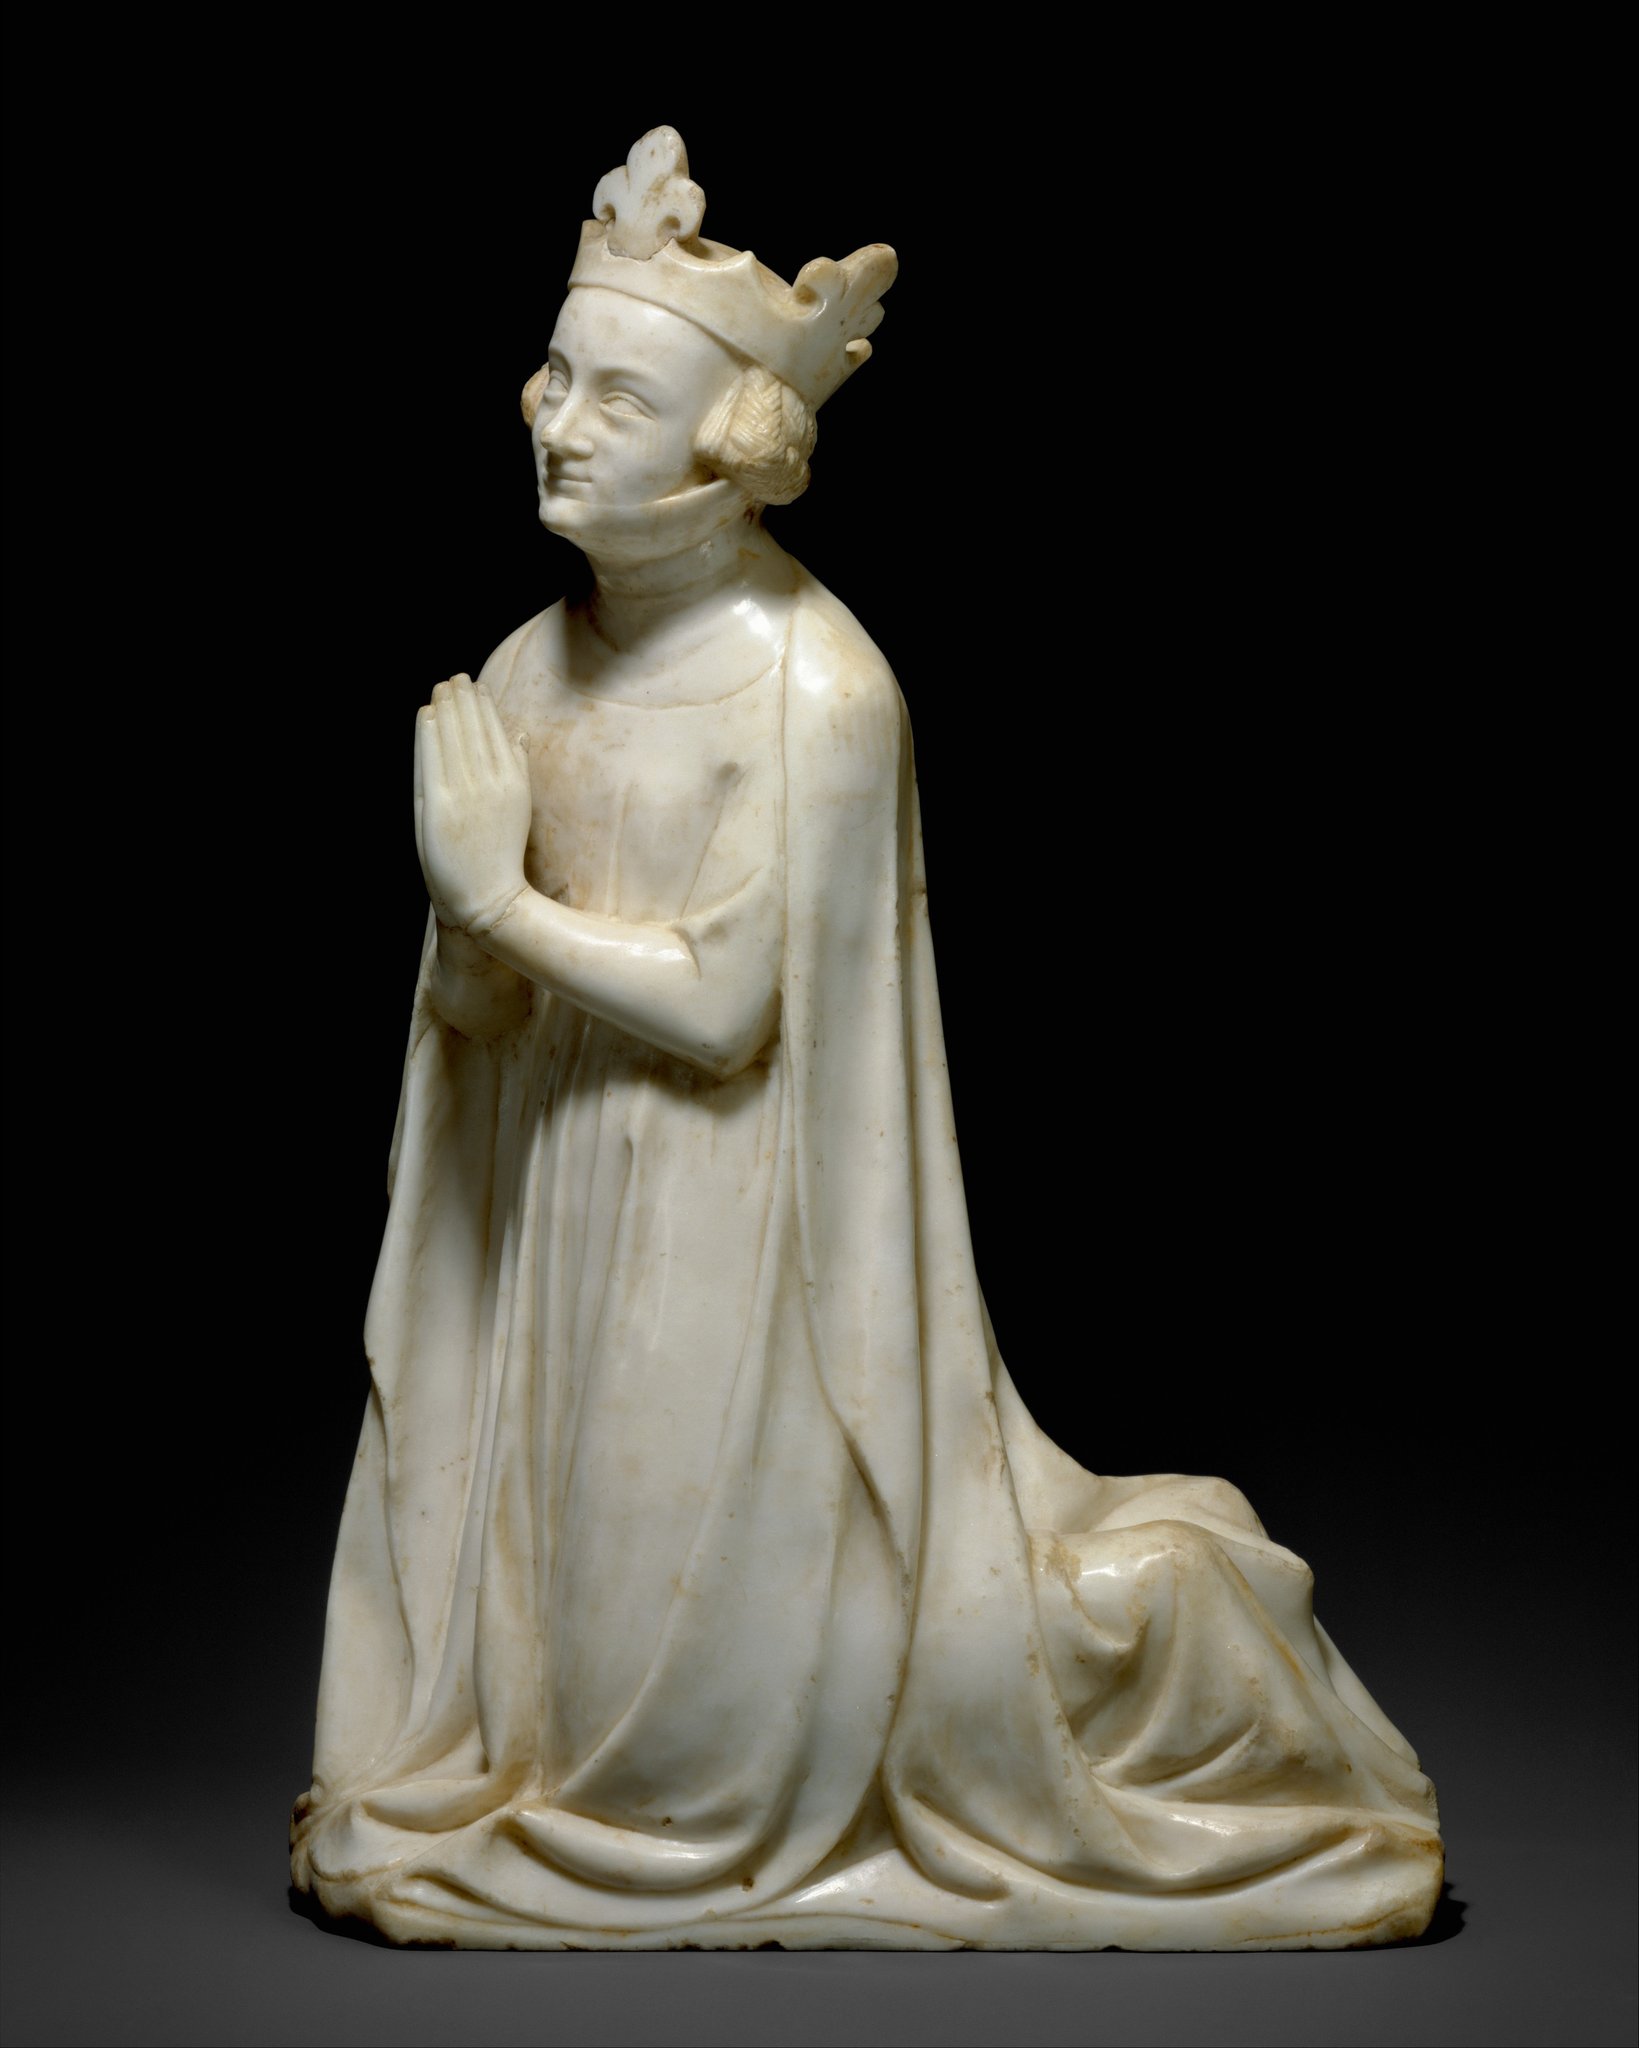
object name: statuette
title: Queen, from a group of Donor Figures including a King, Queen, and Prince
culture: french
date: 1350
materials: marble, paint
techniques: gilding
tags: queens,women,praying